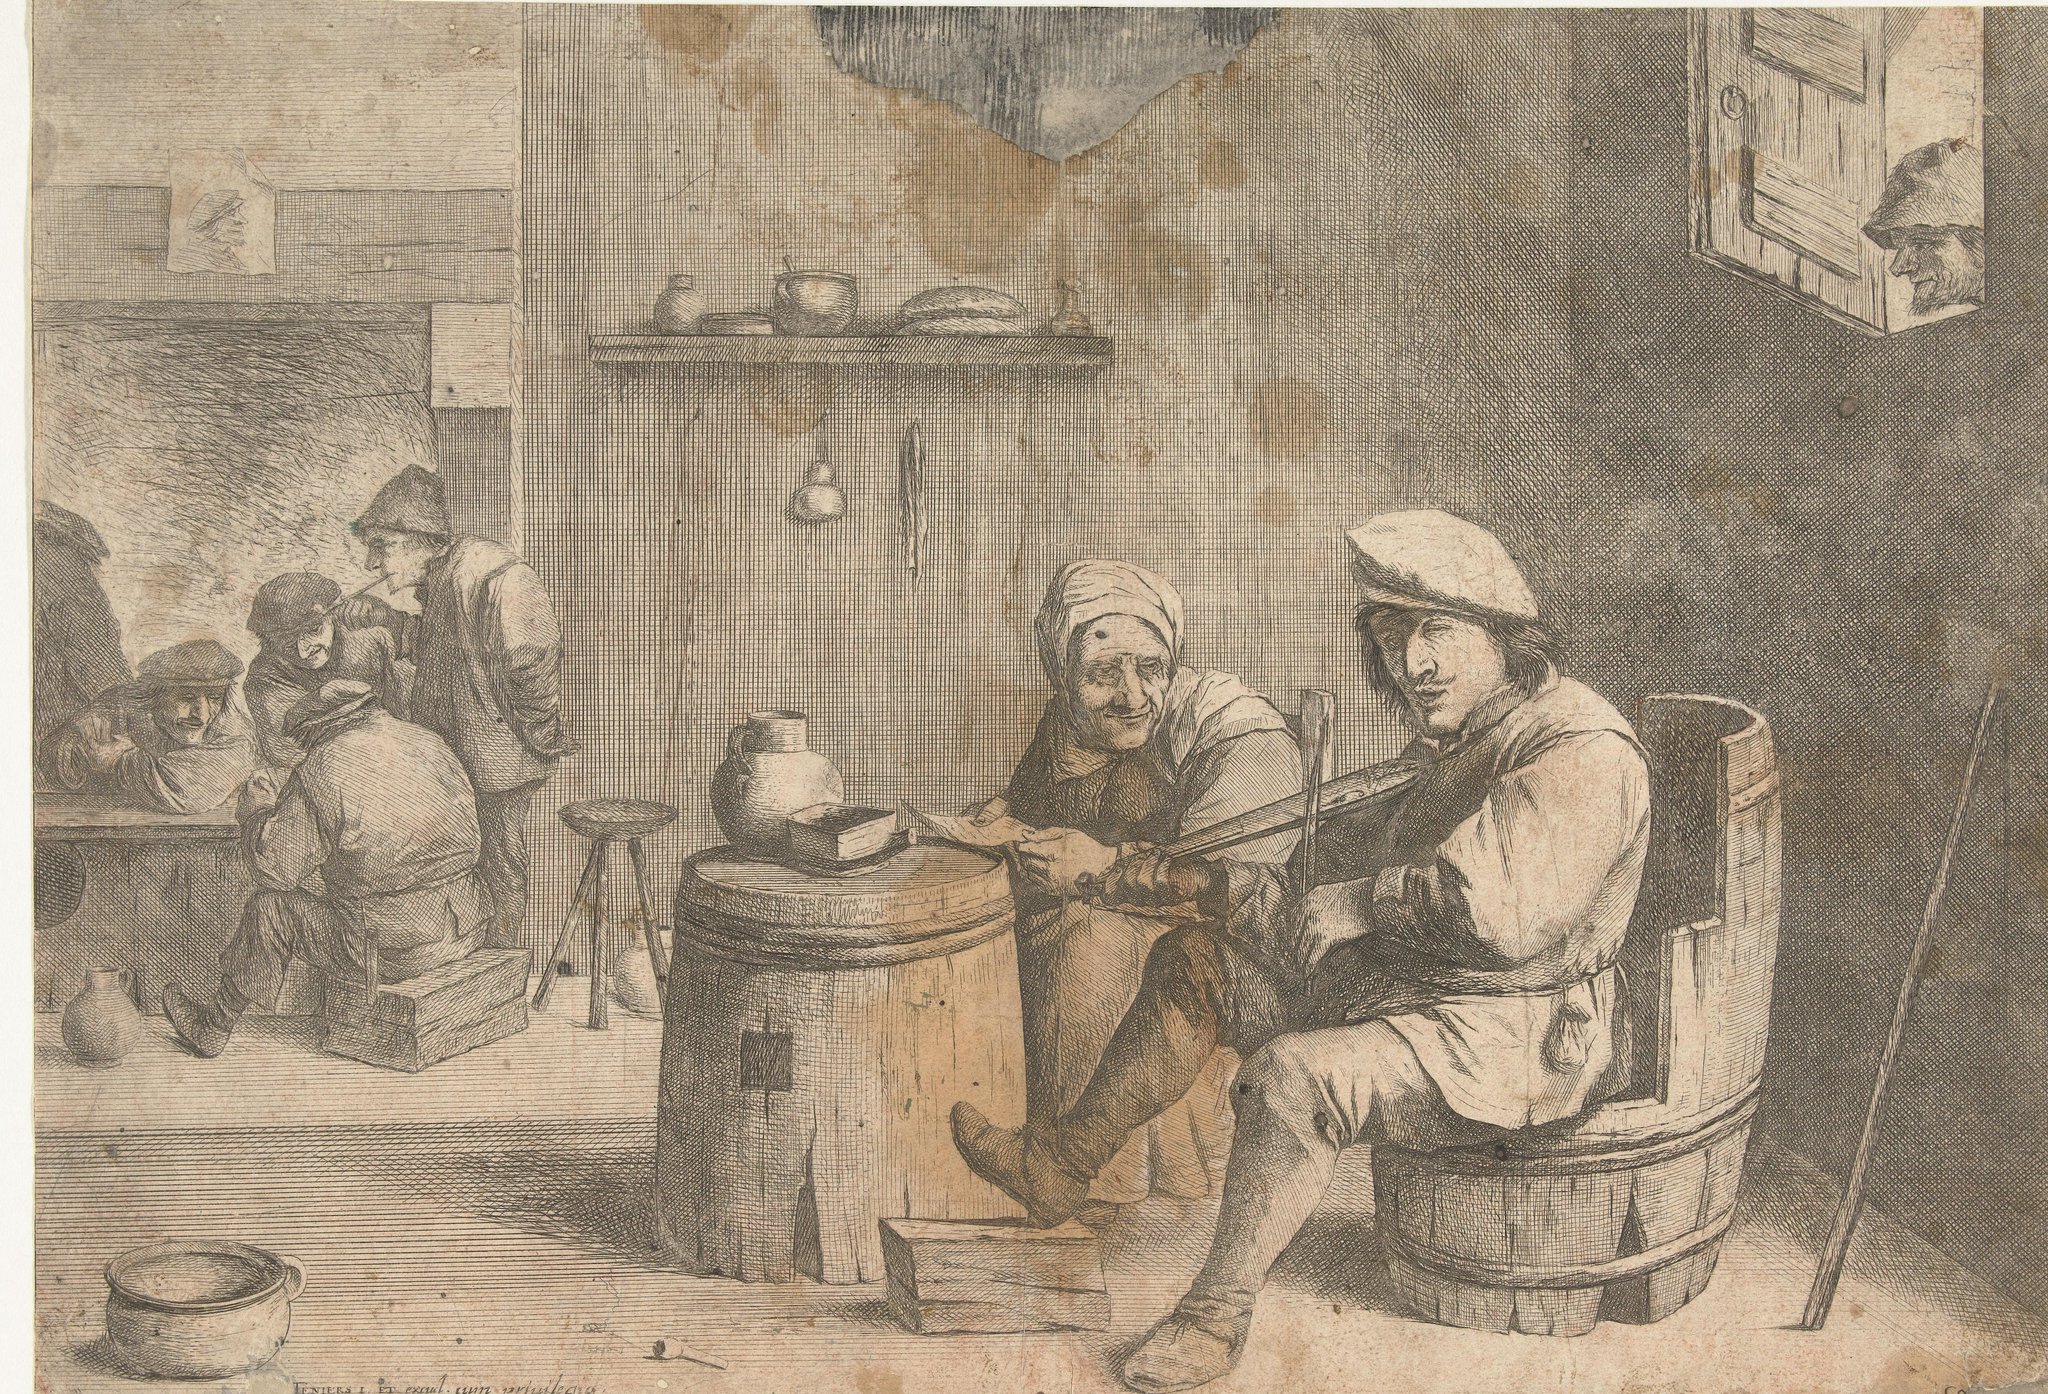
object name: print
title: Vioolspeler in een kroeg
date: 1635-1668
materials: paper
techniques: etching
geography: southern netherlands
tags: one person playing string instrument (bowed), inn, coffee-house, public house, etc.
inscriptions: collector's mark: Lugt 2228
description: In een kroeg speelt een man op een snaarinstrument en zingt erbij. Links zit een groepje mannen te kaarten. Aangelokt door de muziek kijkt een man door het raam naar binnen.